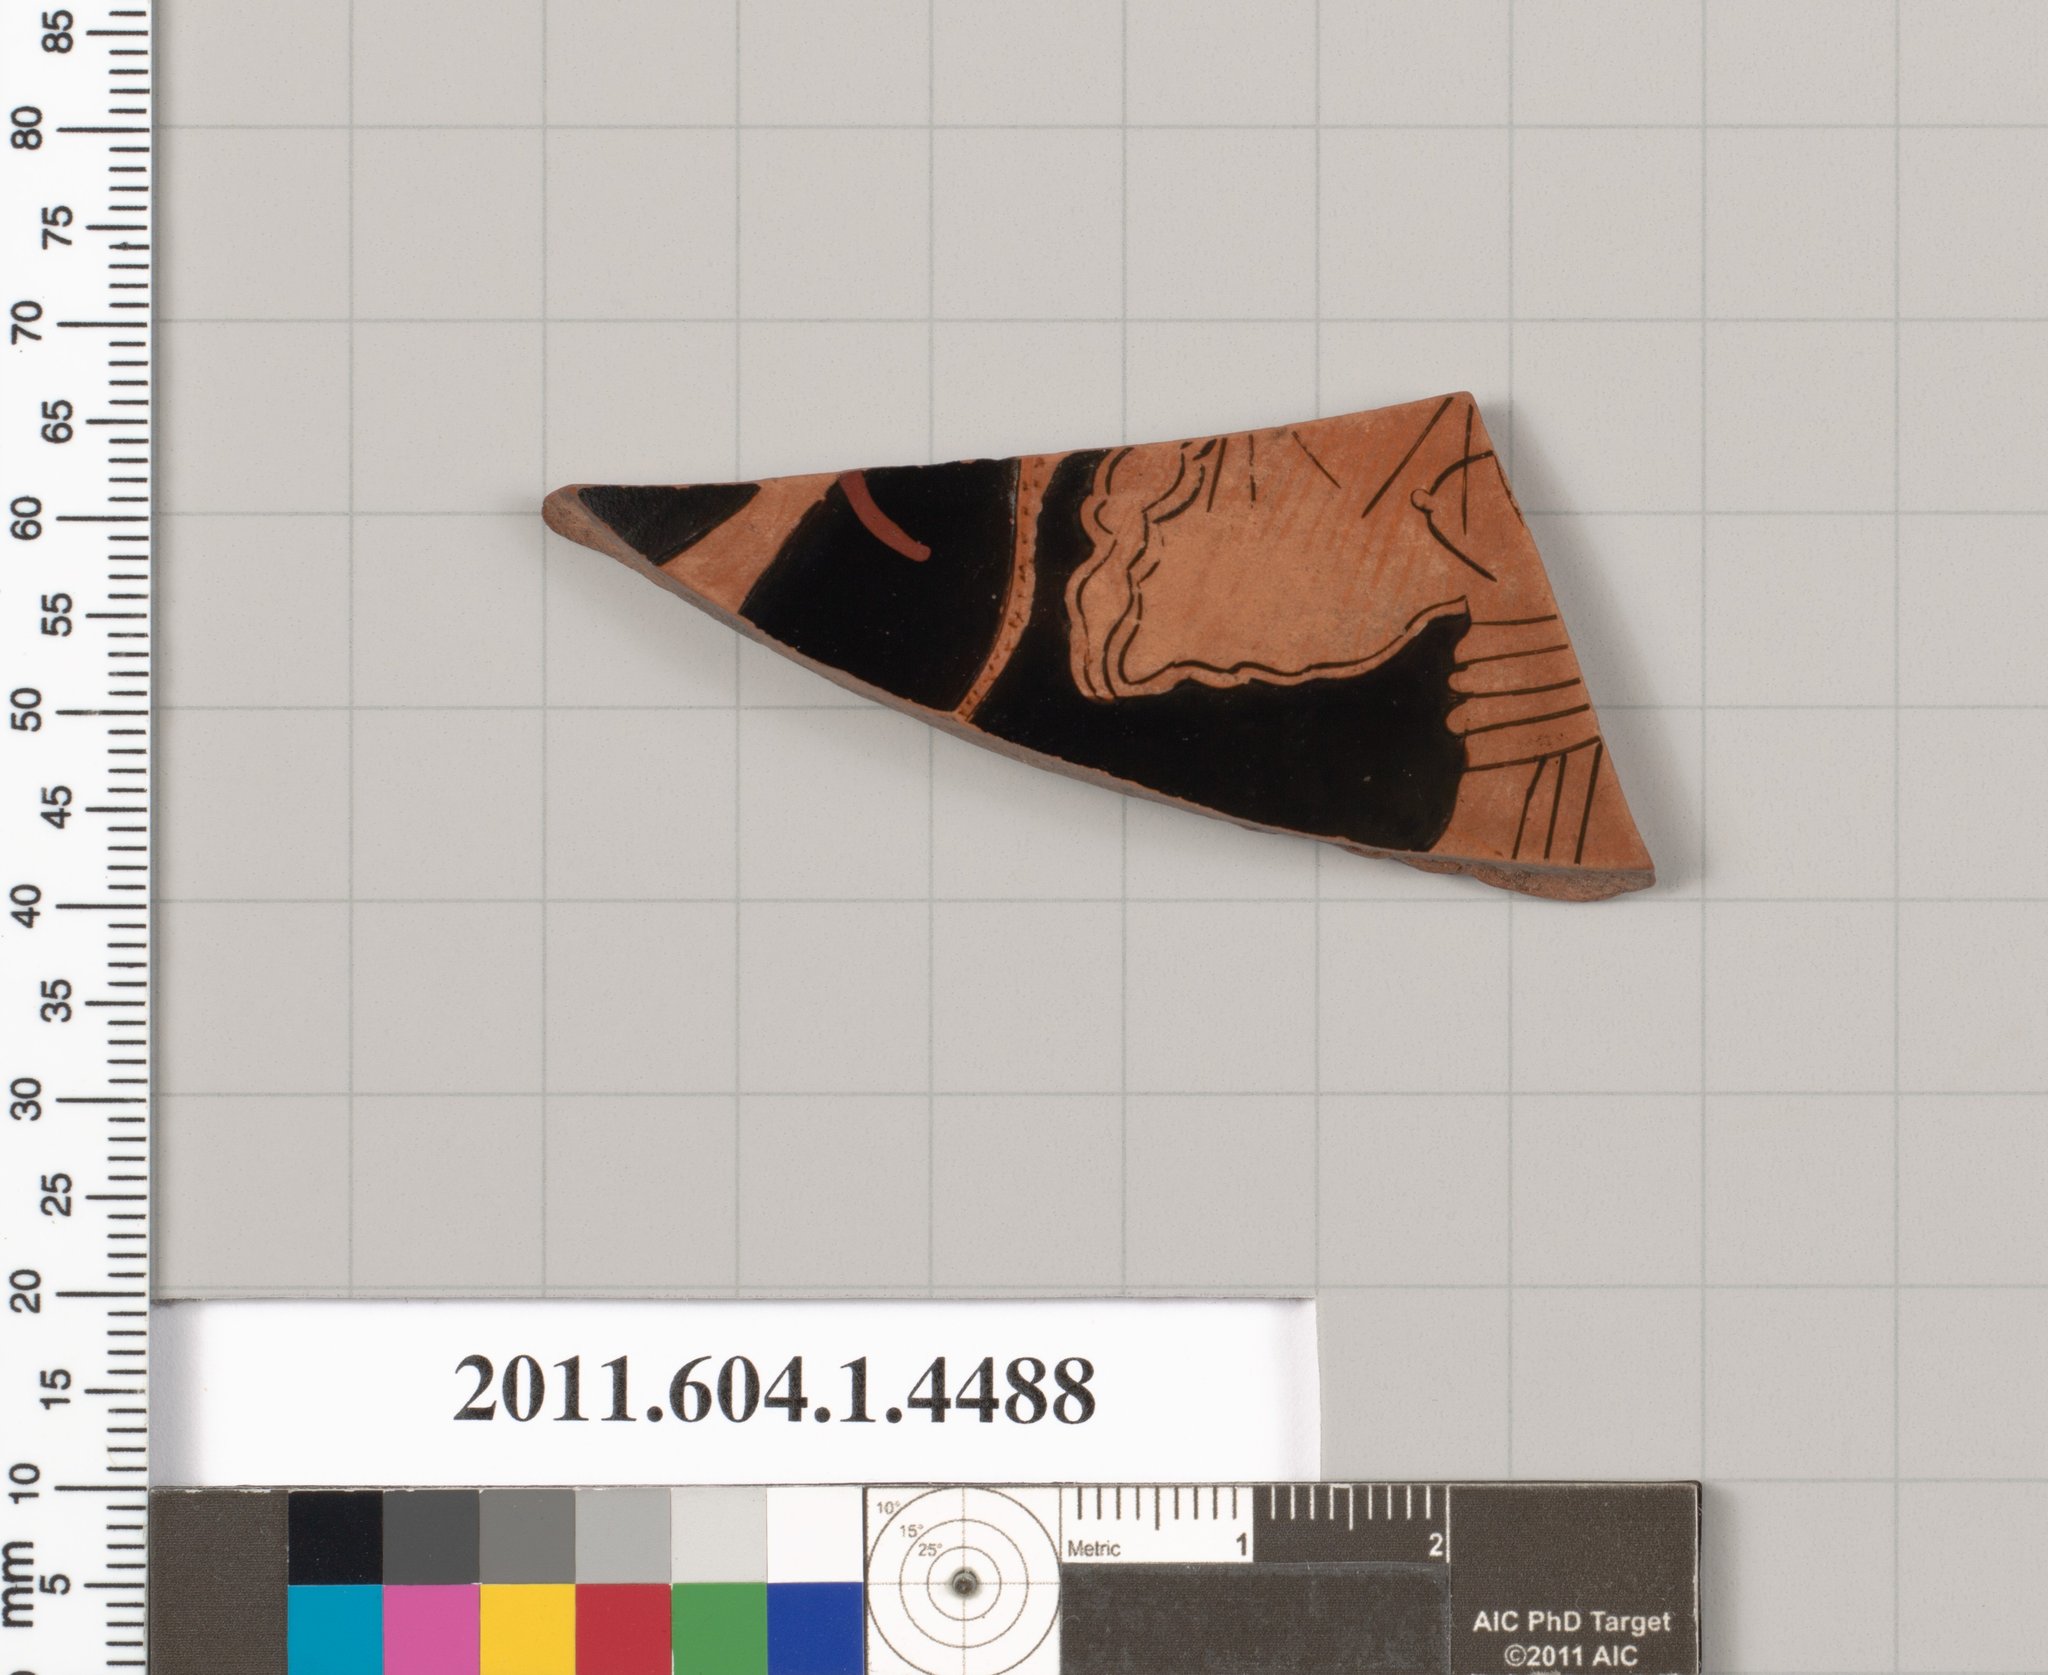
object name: kylix fragment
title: Terracotta fragment of a kylix (drinking cup)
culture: greek, attic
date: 490-480 BCE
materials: terracotta